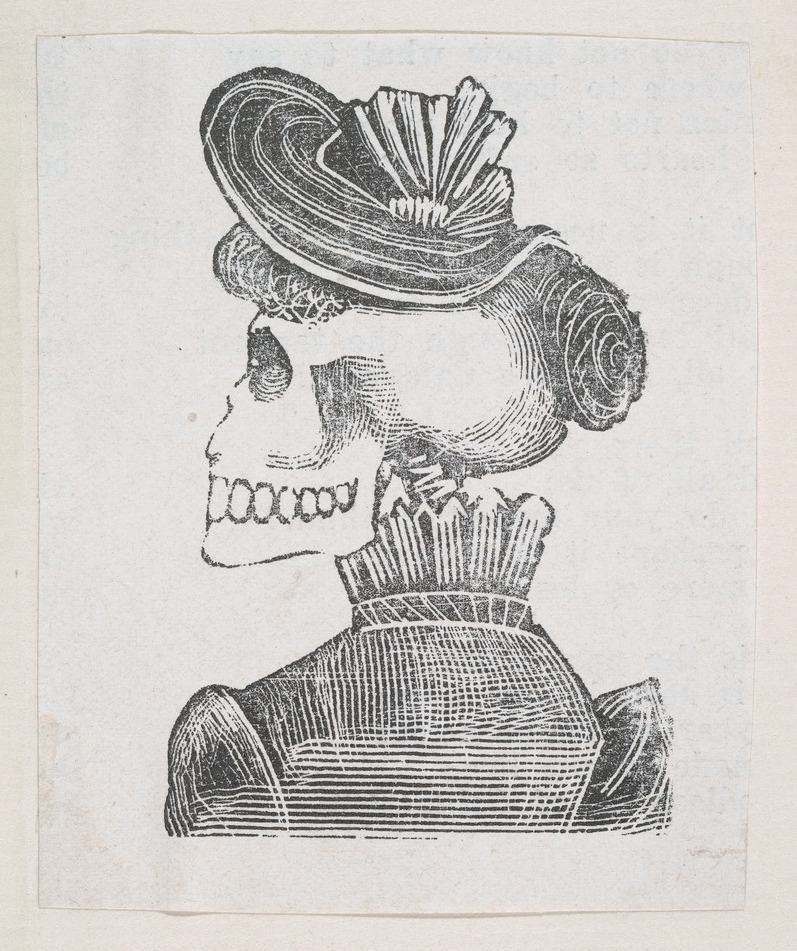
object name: print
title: A skeleton with her back turned wearing a coat and hat, from a broaside entitled 'La Calavera de Cupido', published by Antonio Vanegas Arroyo.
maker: josé guadalupe posada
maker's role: artist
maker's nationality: mexican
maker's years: 1852-1913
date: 1892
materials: metal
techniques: engraving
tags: skeletons